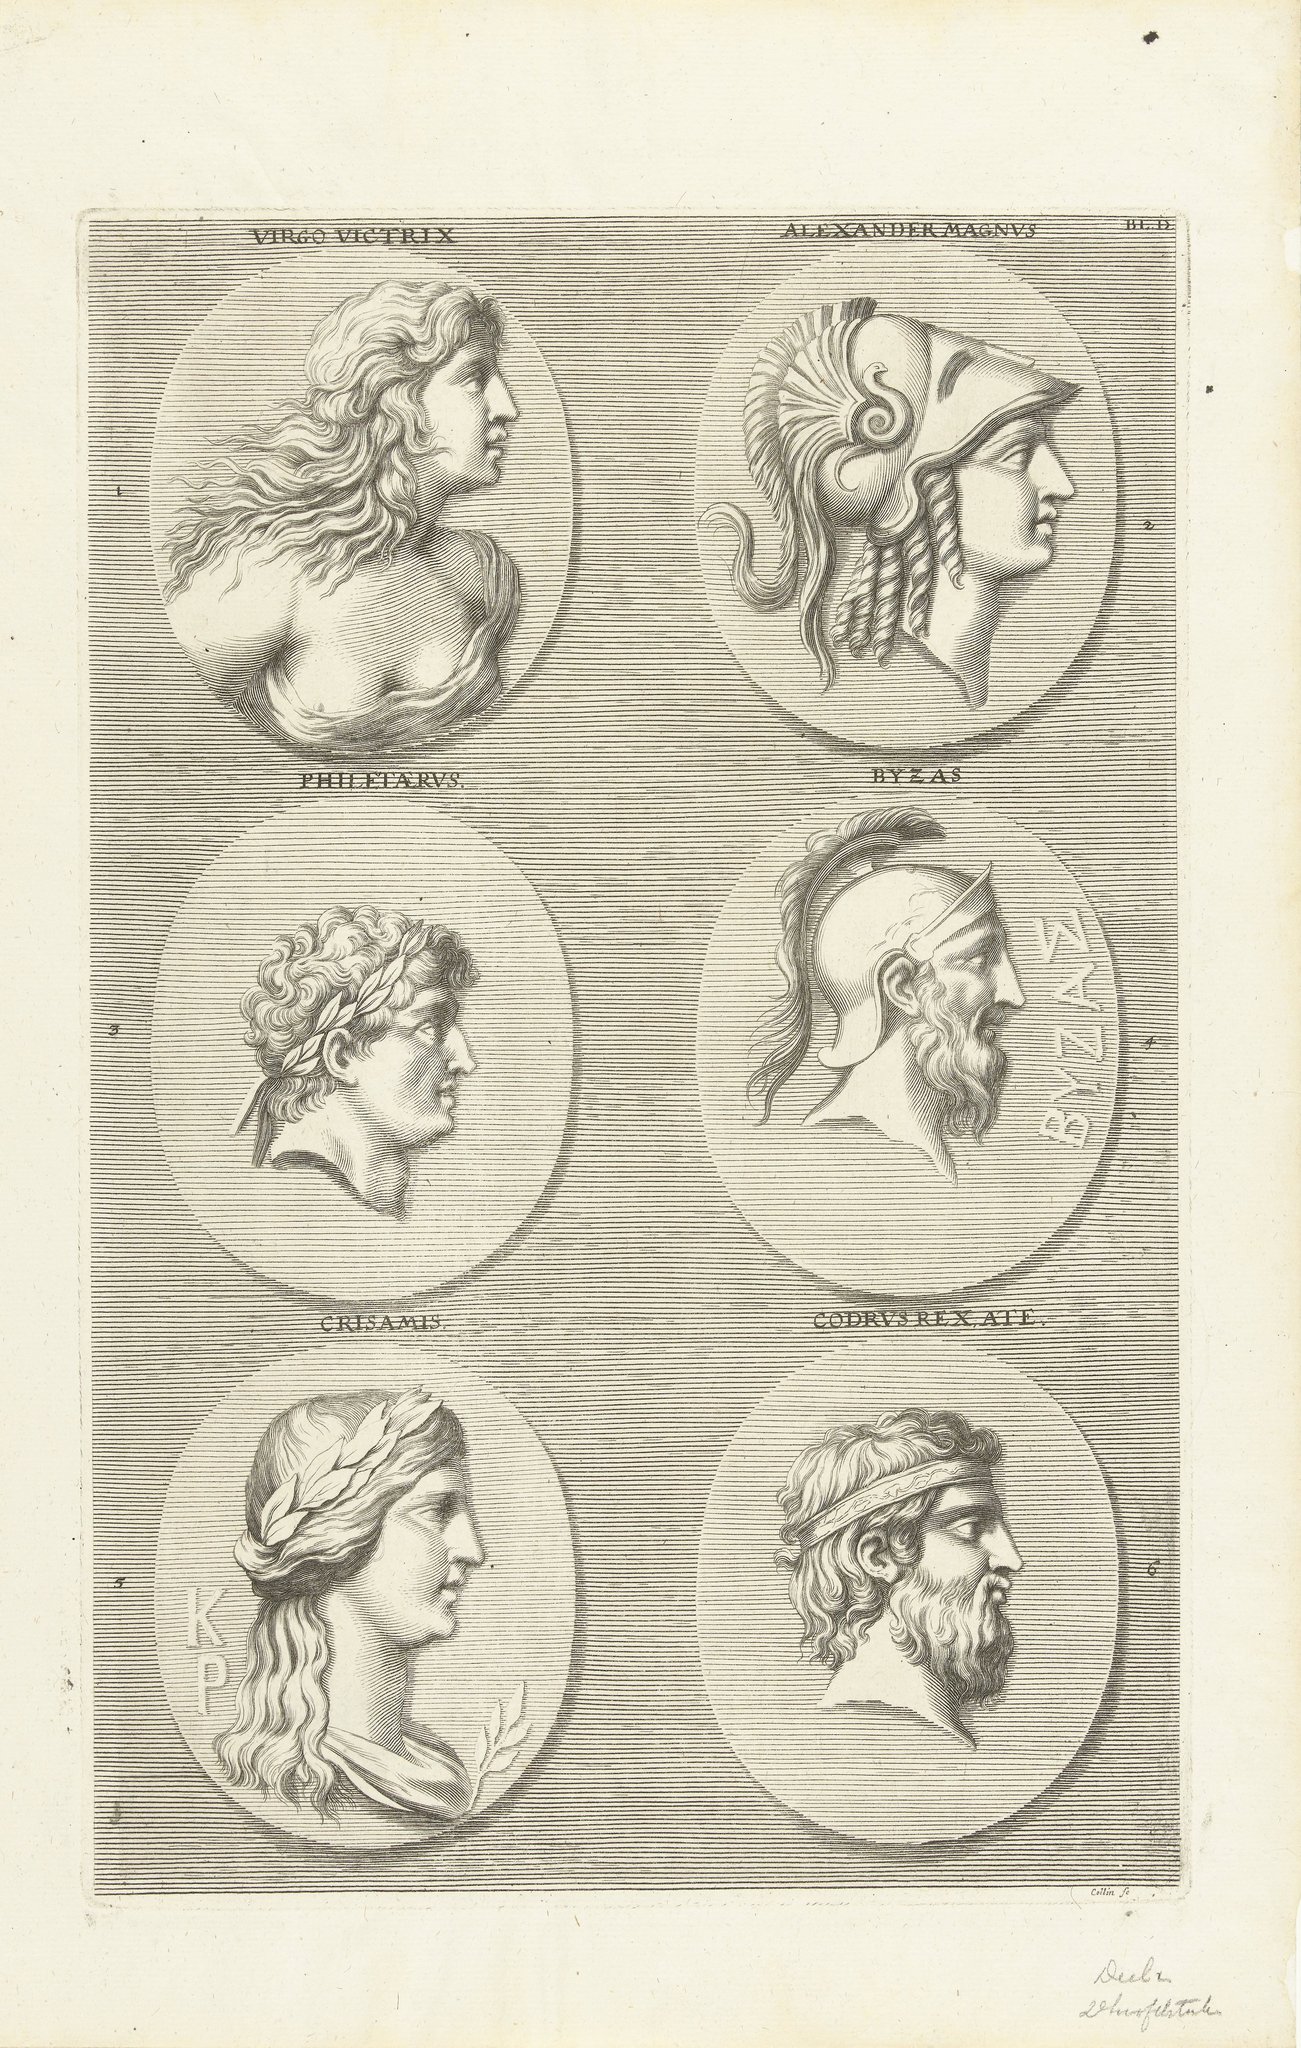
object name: book illustration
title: Zes munten met portretten van mannen en vrouwen uit de klassieke oudheid: letter BL D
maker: richard collin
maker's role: print maker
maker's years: 1627-1697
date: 1675-1680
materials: paper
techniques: engraving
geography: antwerp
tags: coin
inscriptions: collector's mark: Lugt 2228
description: Illustratie voor: Joachim von Sandrart, L'Academia Todesca della Architectura Scultura e Pittura oder Teutsche Academie der Edlen Bau-, Bild- und Mahlerey-Künste. Nürnberg: 1675-1680.